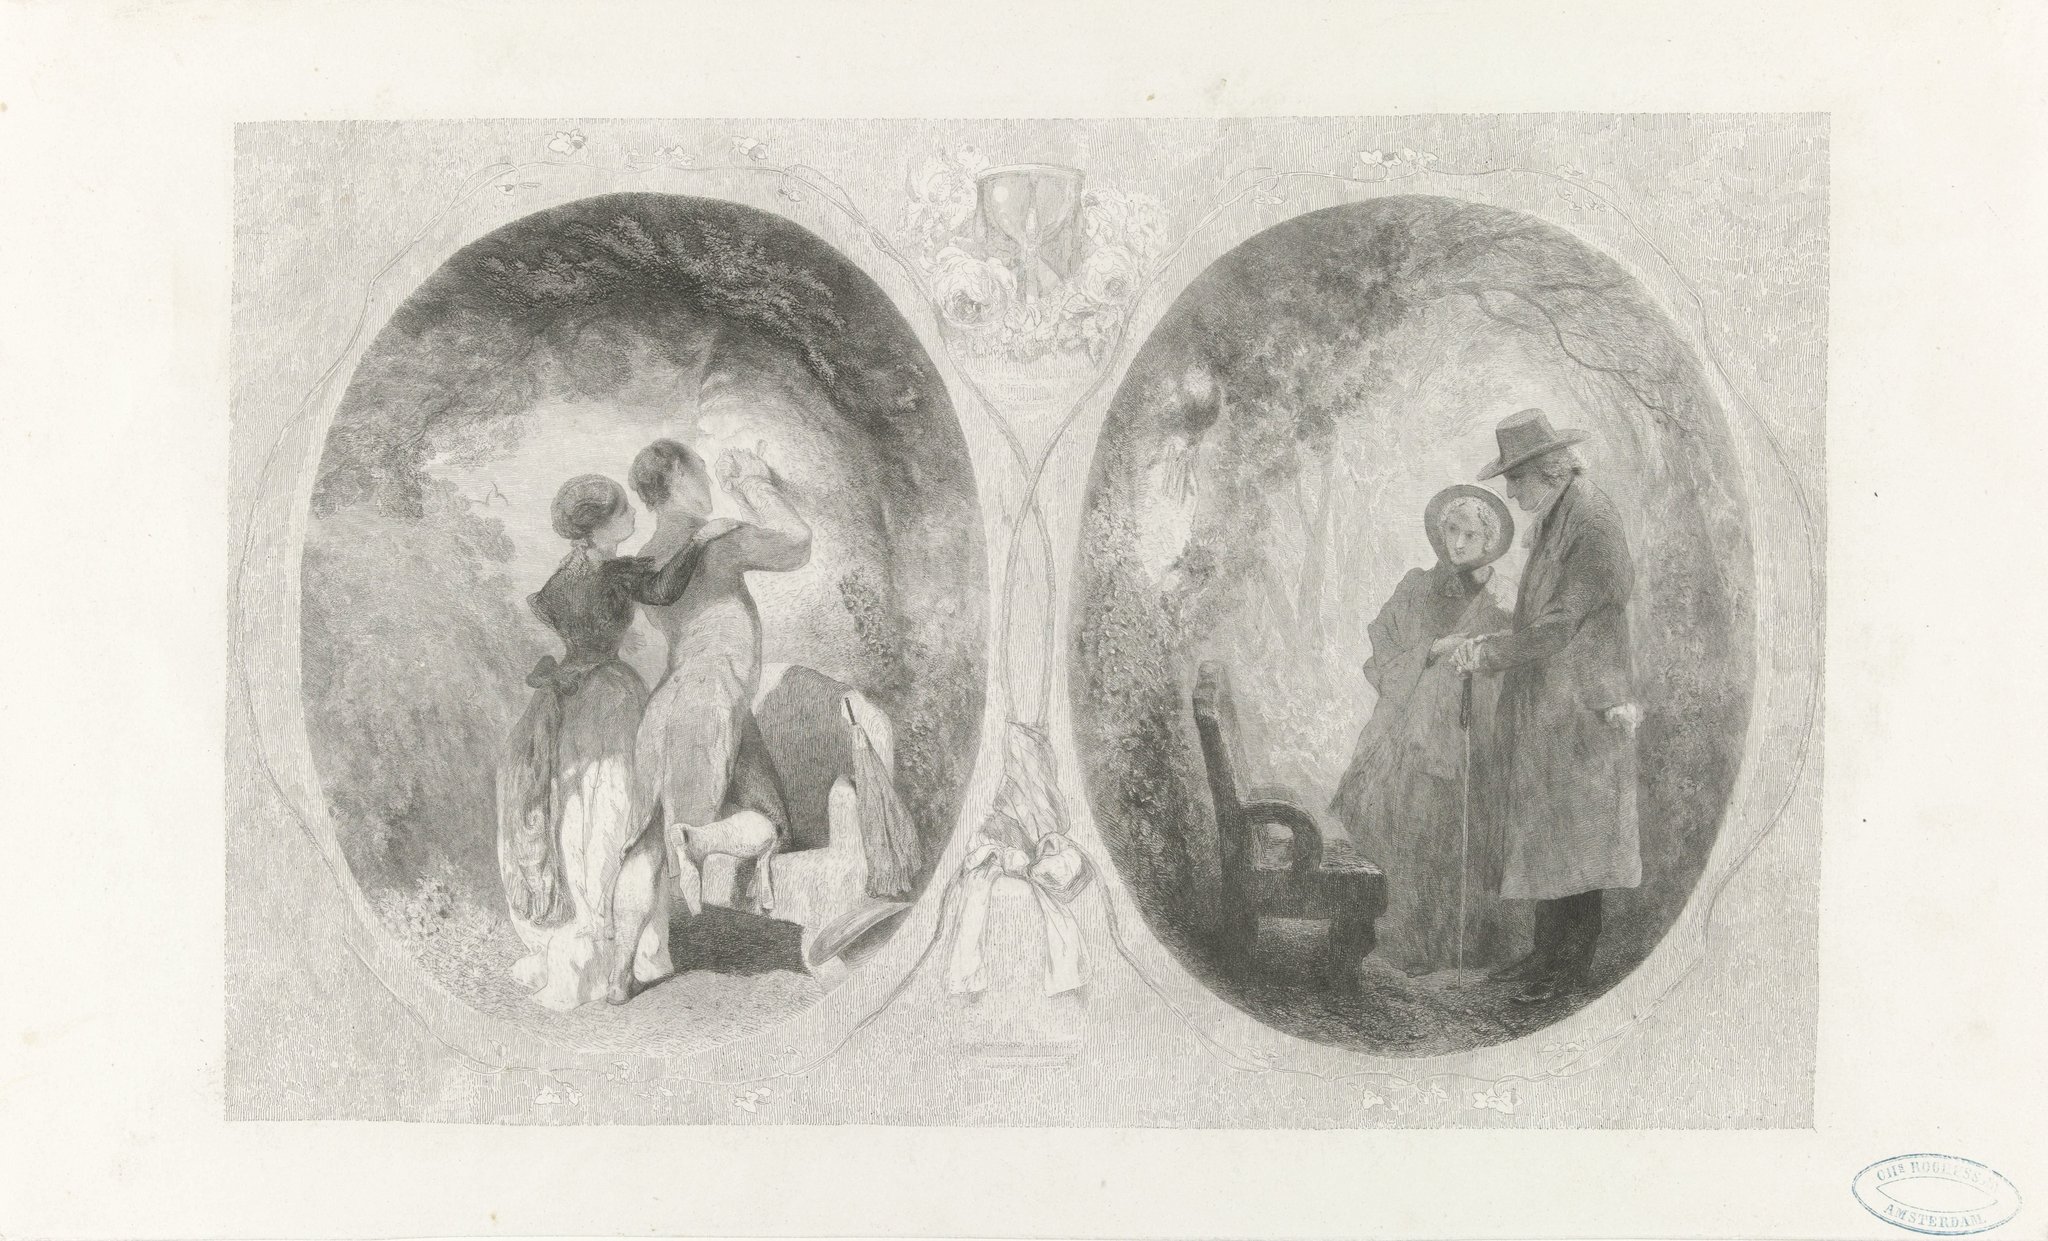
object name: print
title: Twee ovalen met een jong en oud paar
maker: charles rochussen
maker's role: draughtsman, painter, print maker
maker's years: 1814-1894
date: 1855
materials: paper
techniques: etching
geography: amsterdam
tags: forest, wood, lovers' meeting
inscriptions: collector's mark: Lugt 2228, workshop stamp: ‘Charles Rochussen’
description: Twee afbeeldingen in met ranken versierde medaillons. Links: Een jonge man die in het bijzijn van een jonge vrouw de eerste letters van hun namen in een boom snijdt. Rechts: mogelijk hetzelfde paar op dezelfde plaats op hoge leeftijd. Tussen de medaillons een zandloper en een strik.